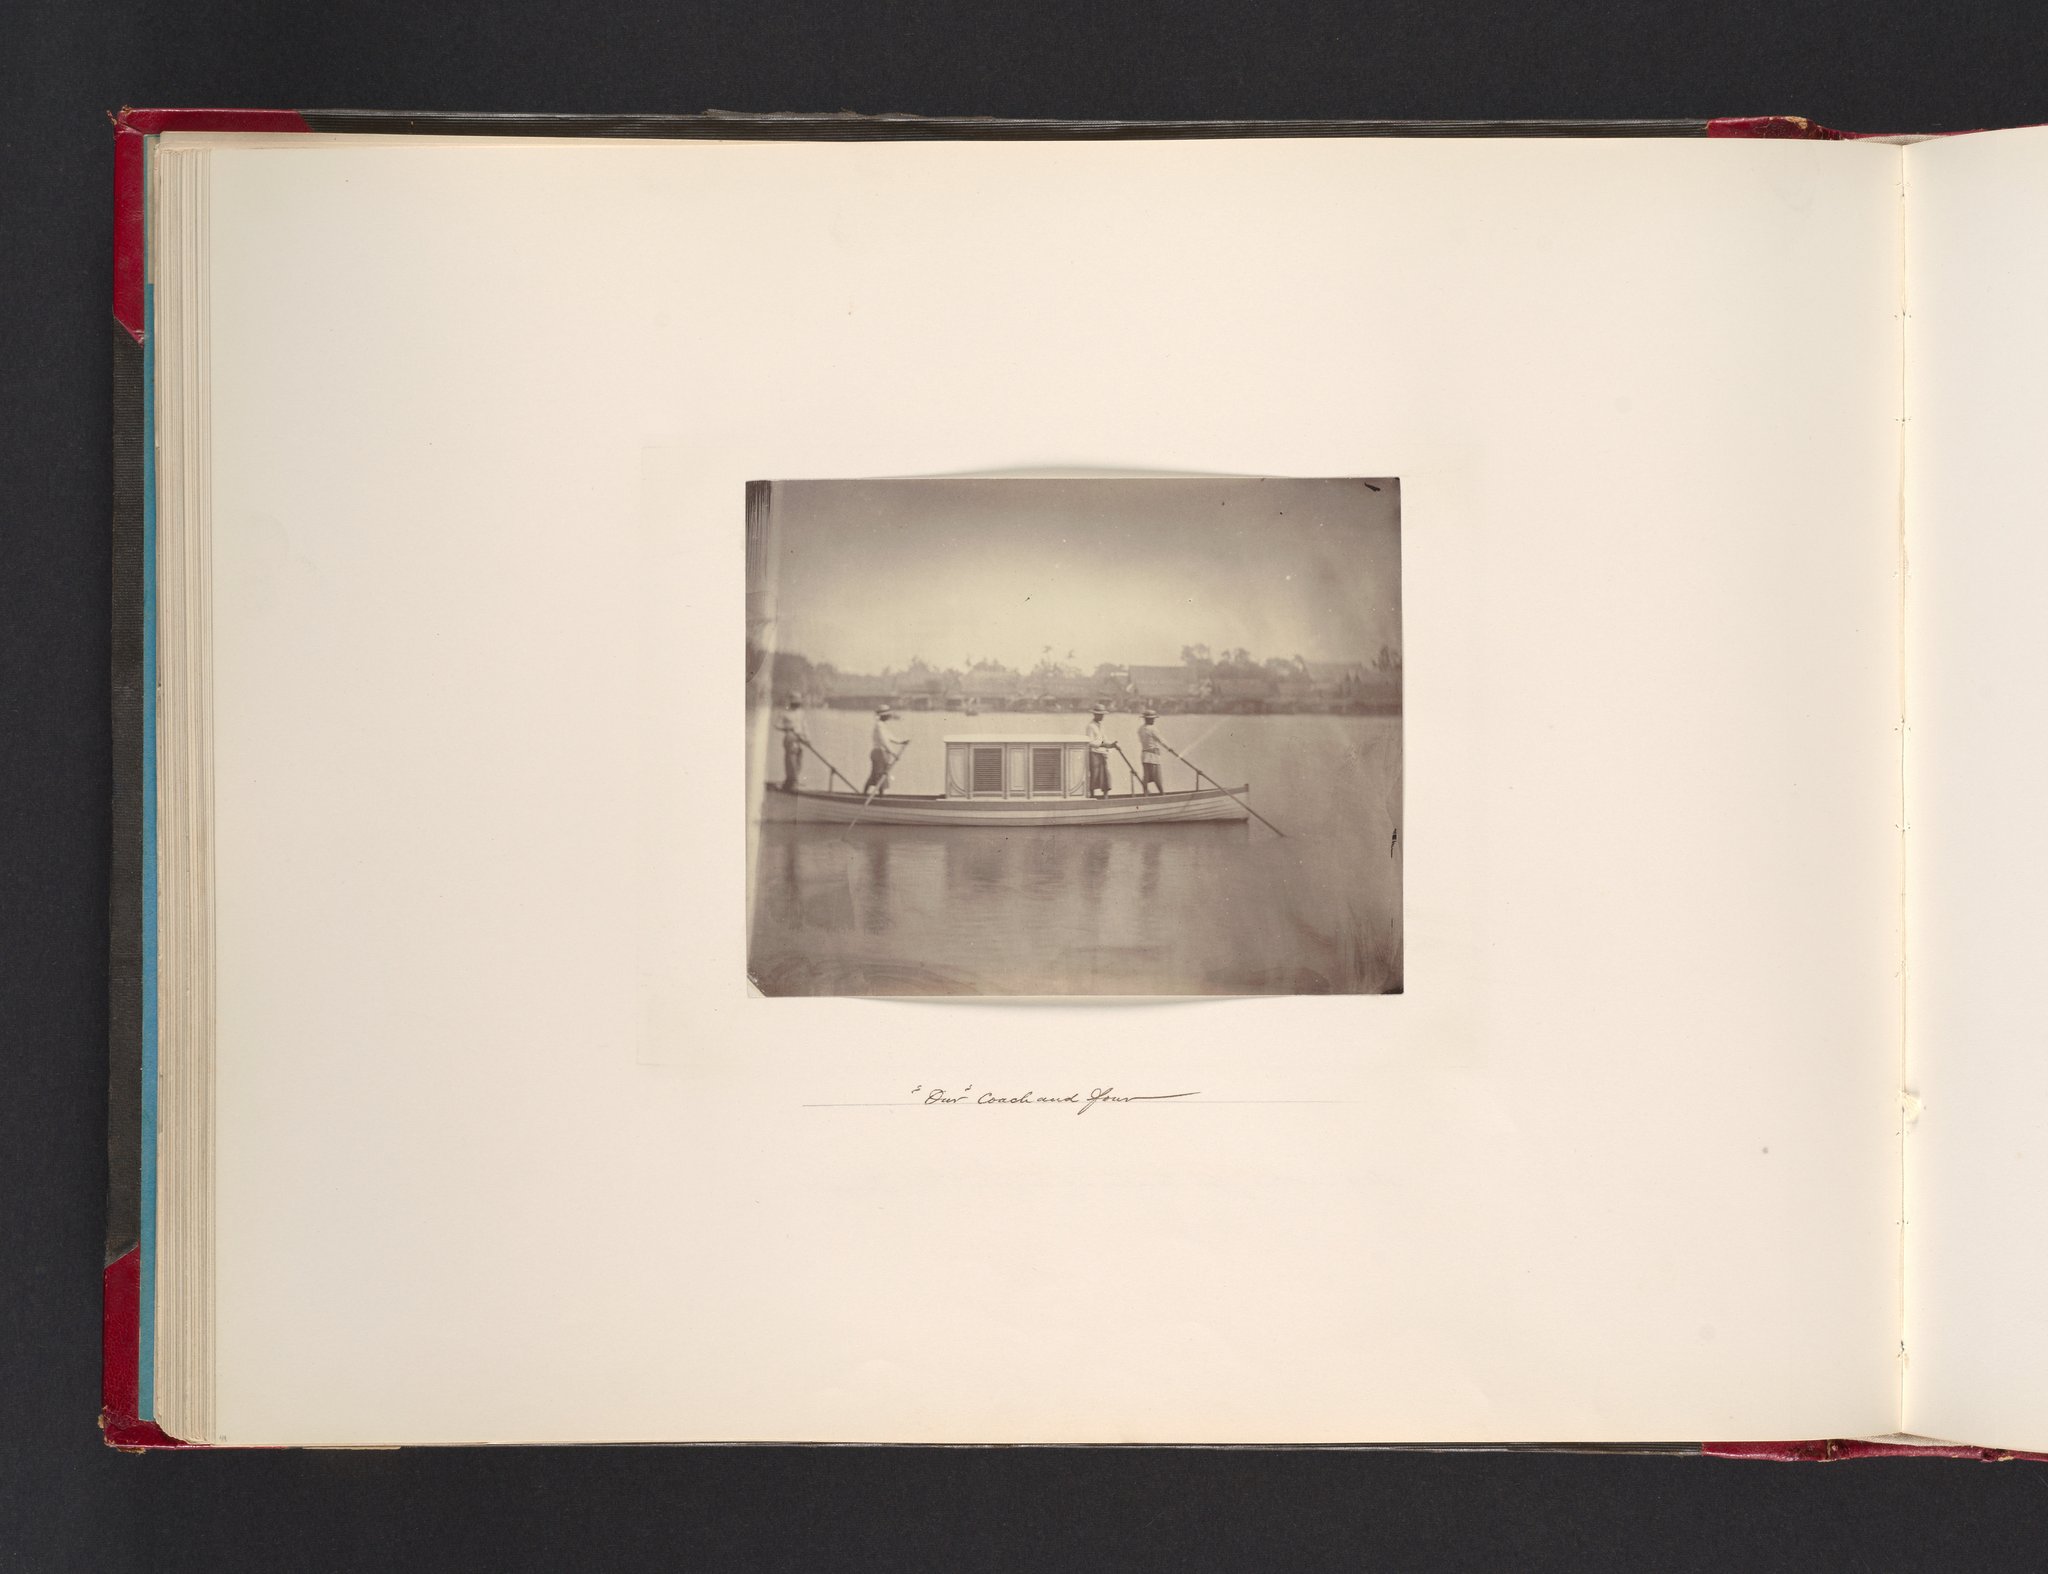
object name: photograph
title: "Our" Coach and Four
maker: john thomson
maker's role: artist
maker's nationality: british, scottish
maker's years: 1837-1921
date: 1865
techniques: albumen silver print, glass negative